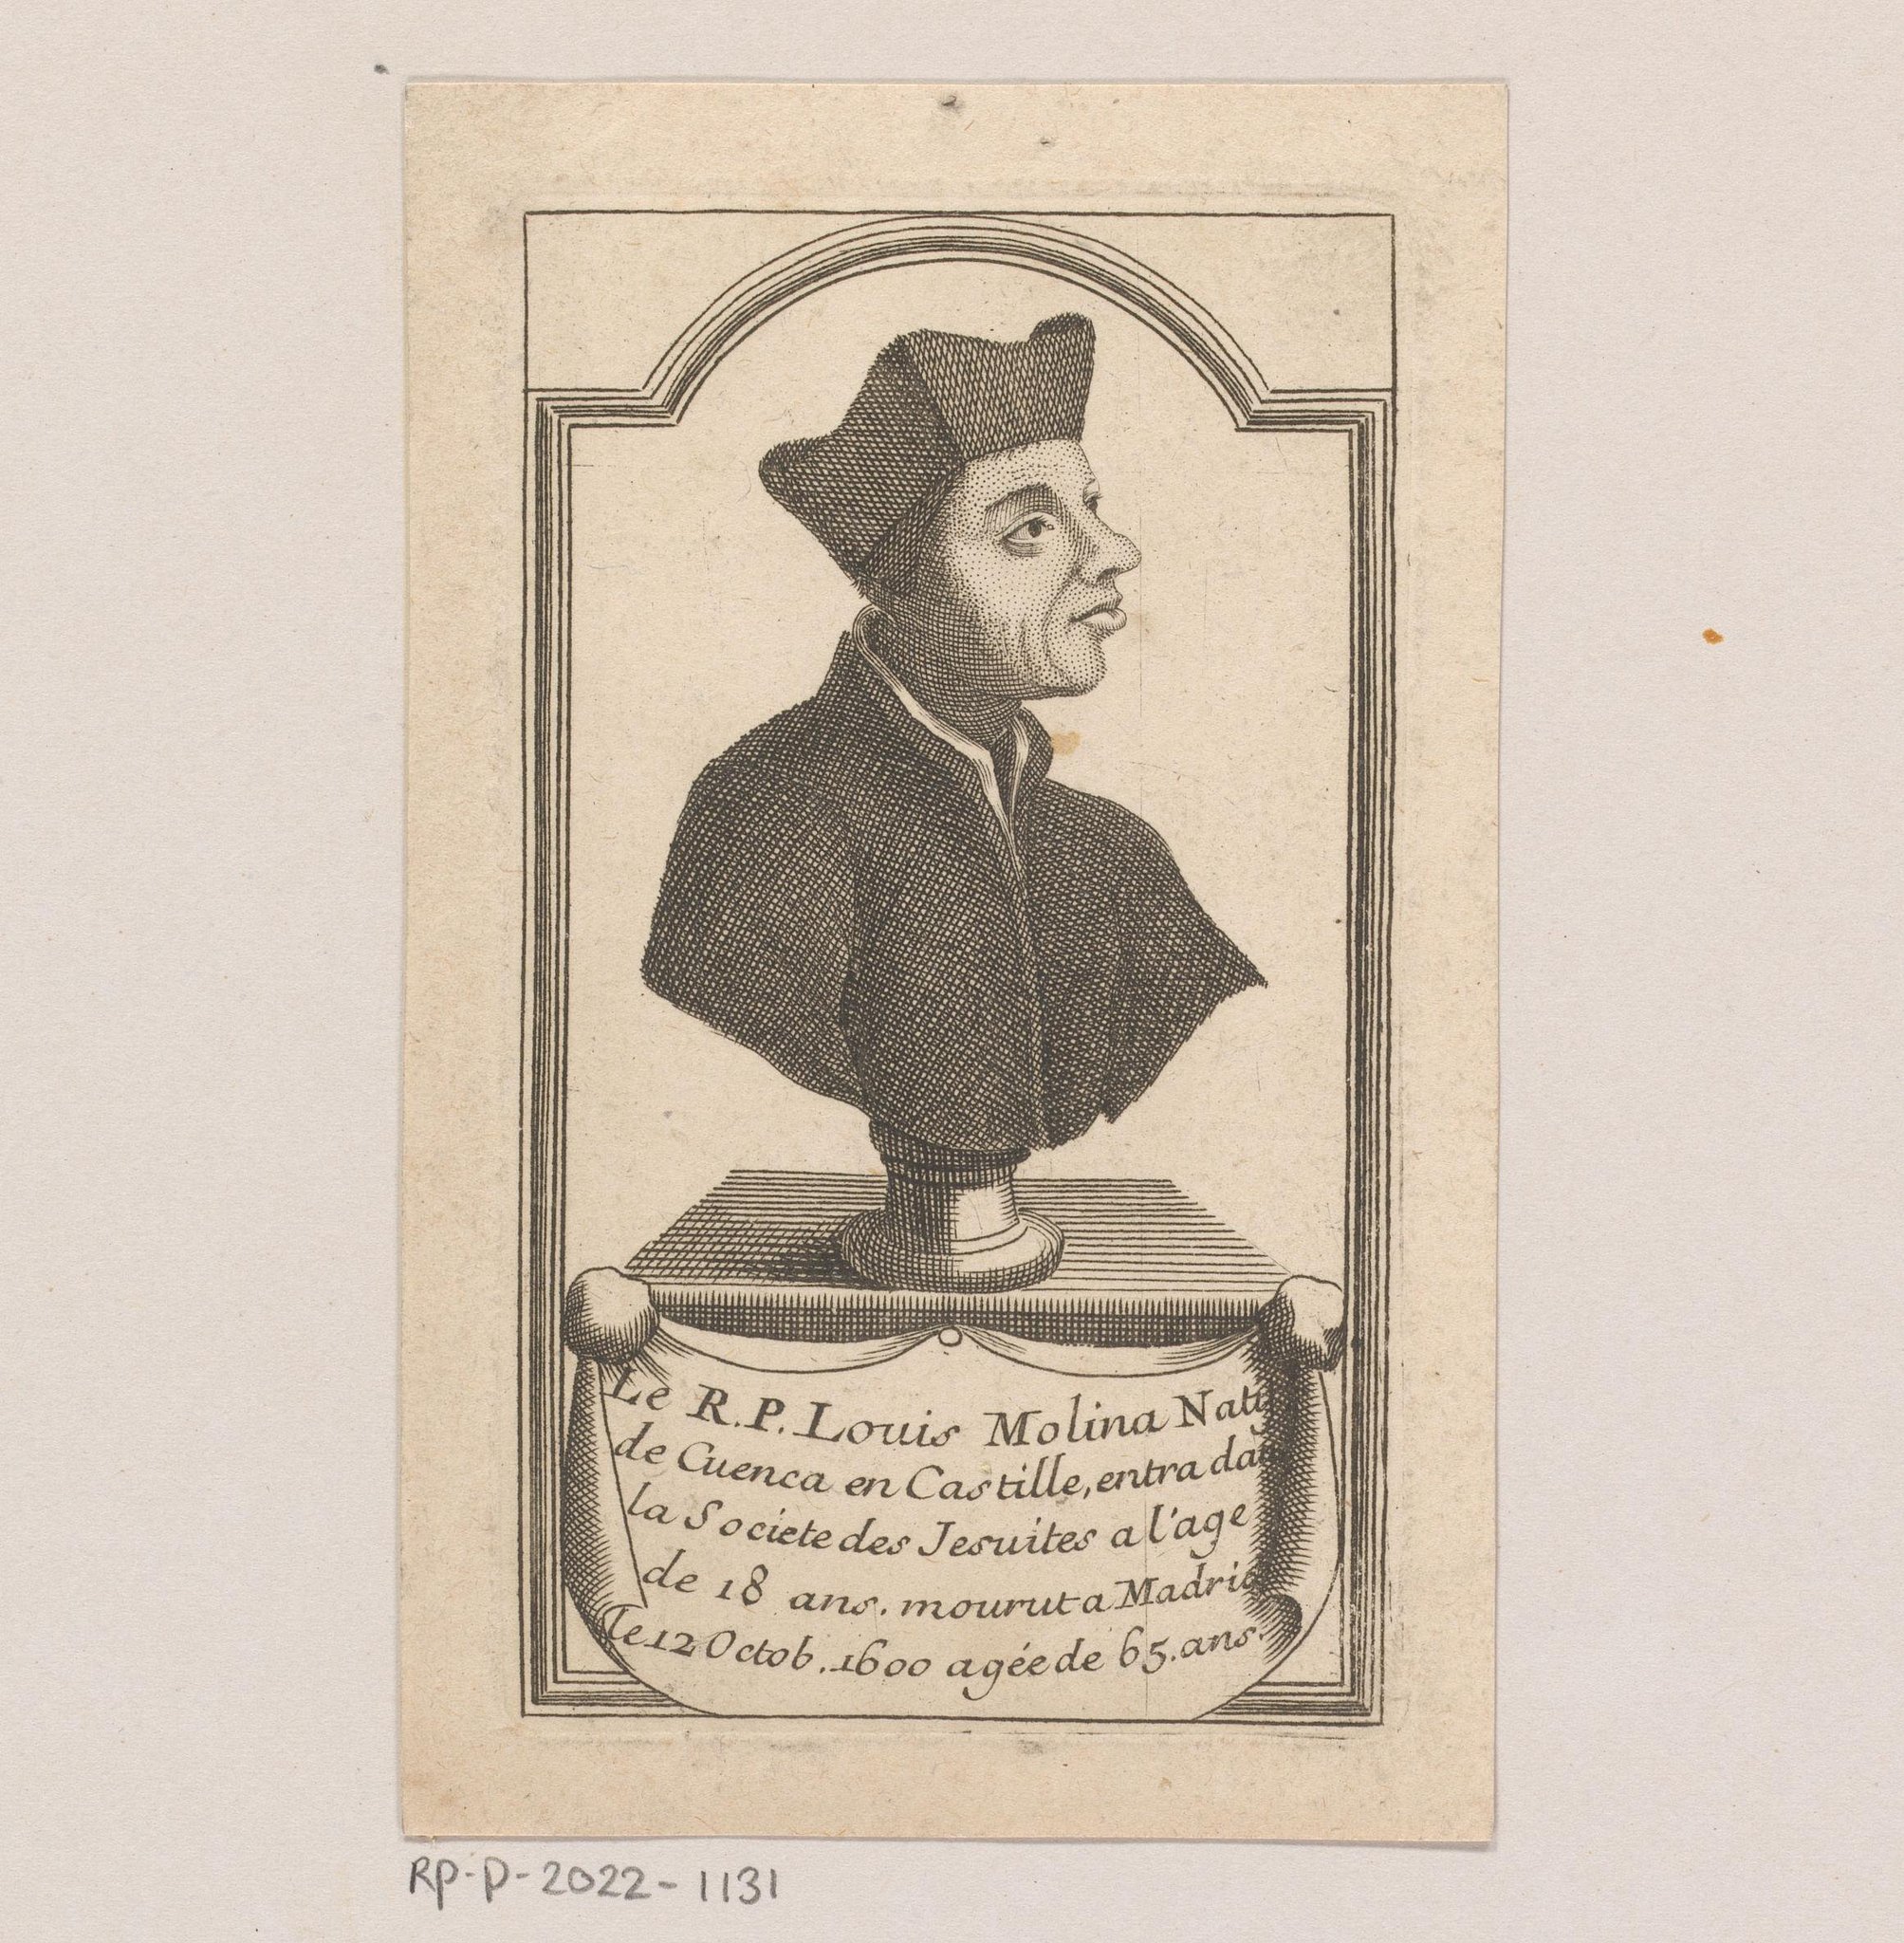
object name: print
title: Portret van Luis de Molina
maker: Anonymous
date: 1600-1750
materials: paper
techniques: engraving, etching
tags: theologian, historical persons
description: Met vijfregelig onderschrift in het Frans.